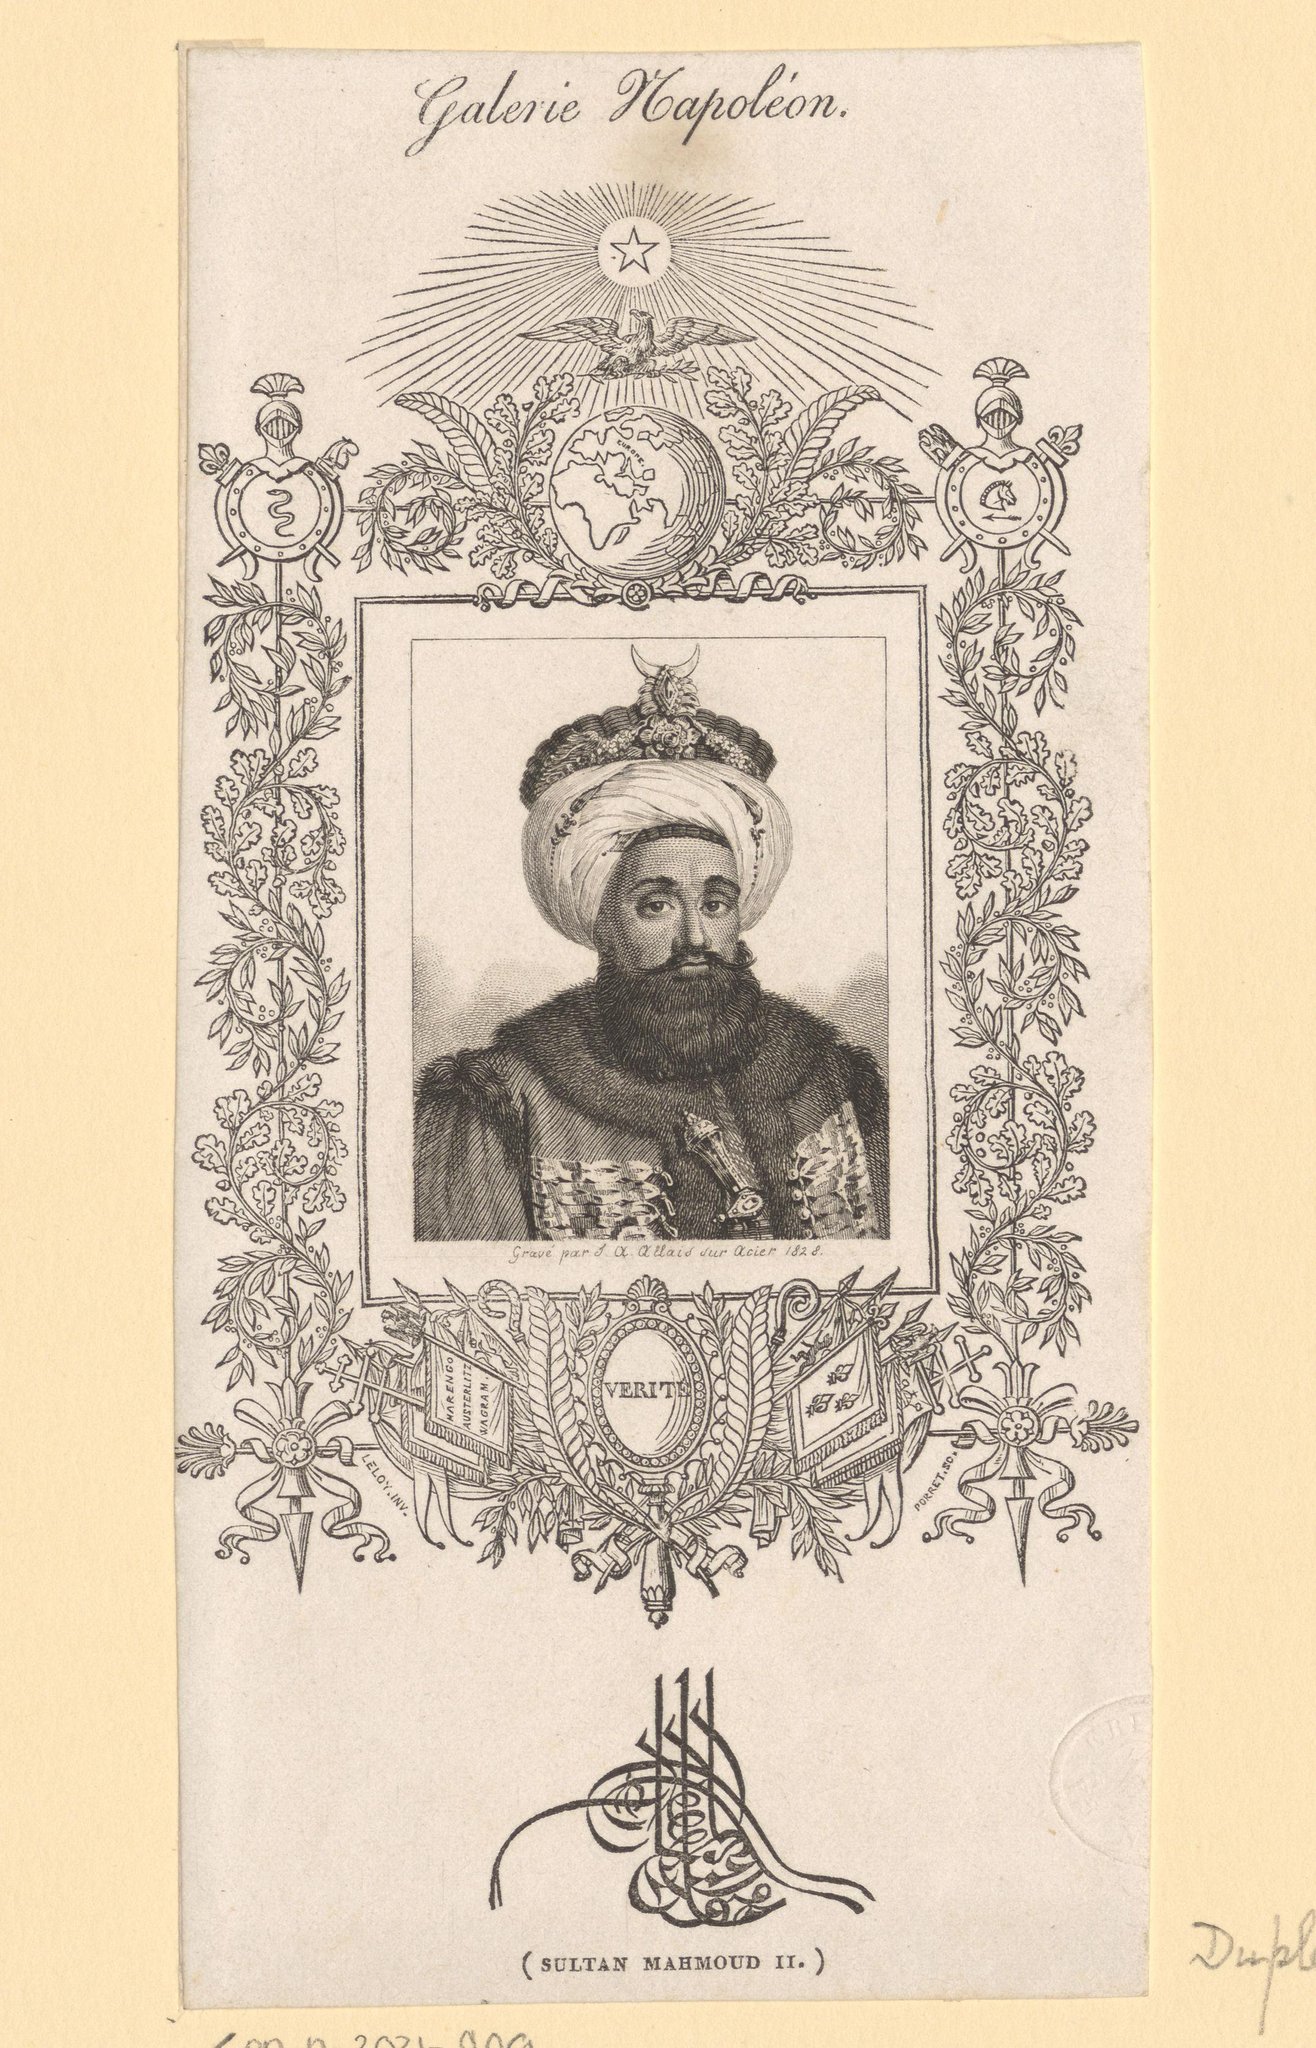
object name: print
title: Galerie Napoléon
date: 1828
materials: paper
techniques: engraving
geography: paris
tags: historical persons, head-gear: turban, ruler, sovereign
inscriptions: check stamp: Lugt 4209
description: Dit portret maakte deel uit van de serie 'Galerie Napoléon', een collectie van honderd portretten van vooraanstaande figuren uit de omgeving van Napoleon Bonaparte. De serie werd uitgegeven door Bénard in Parijs in 1829-1830.